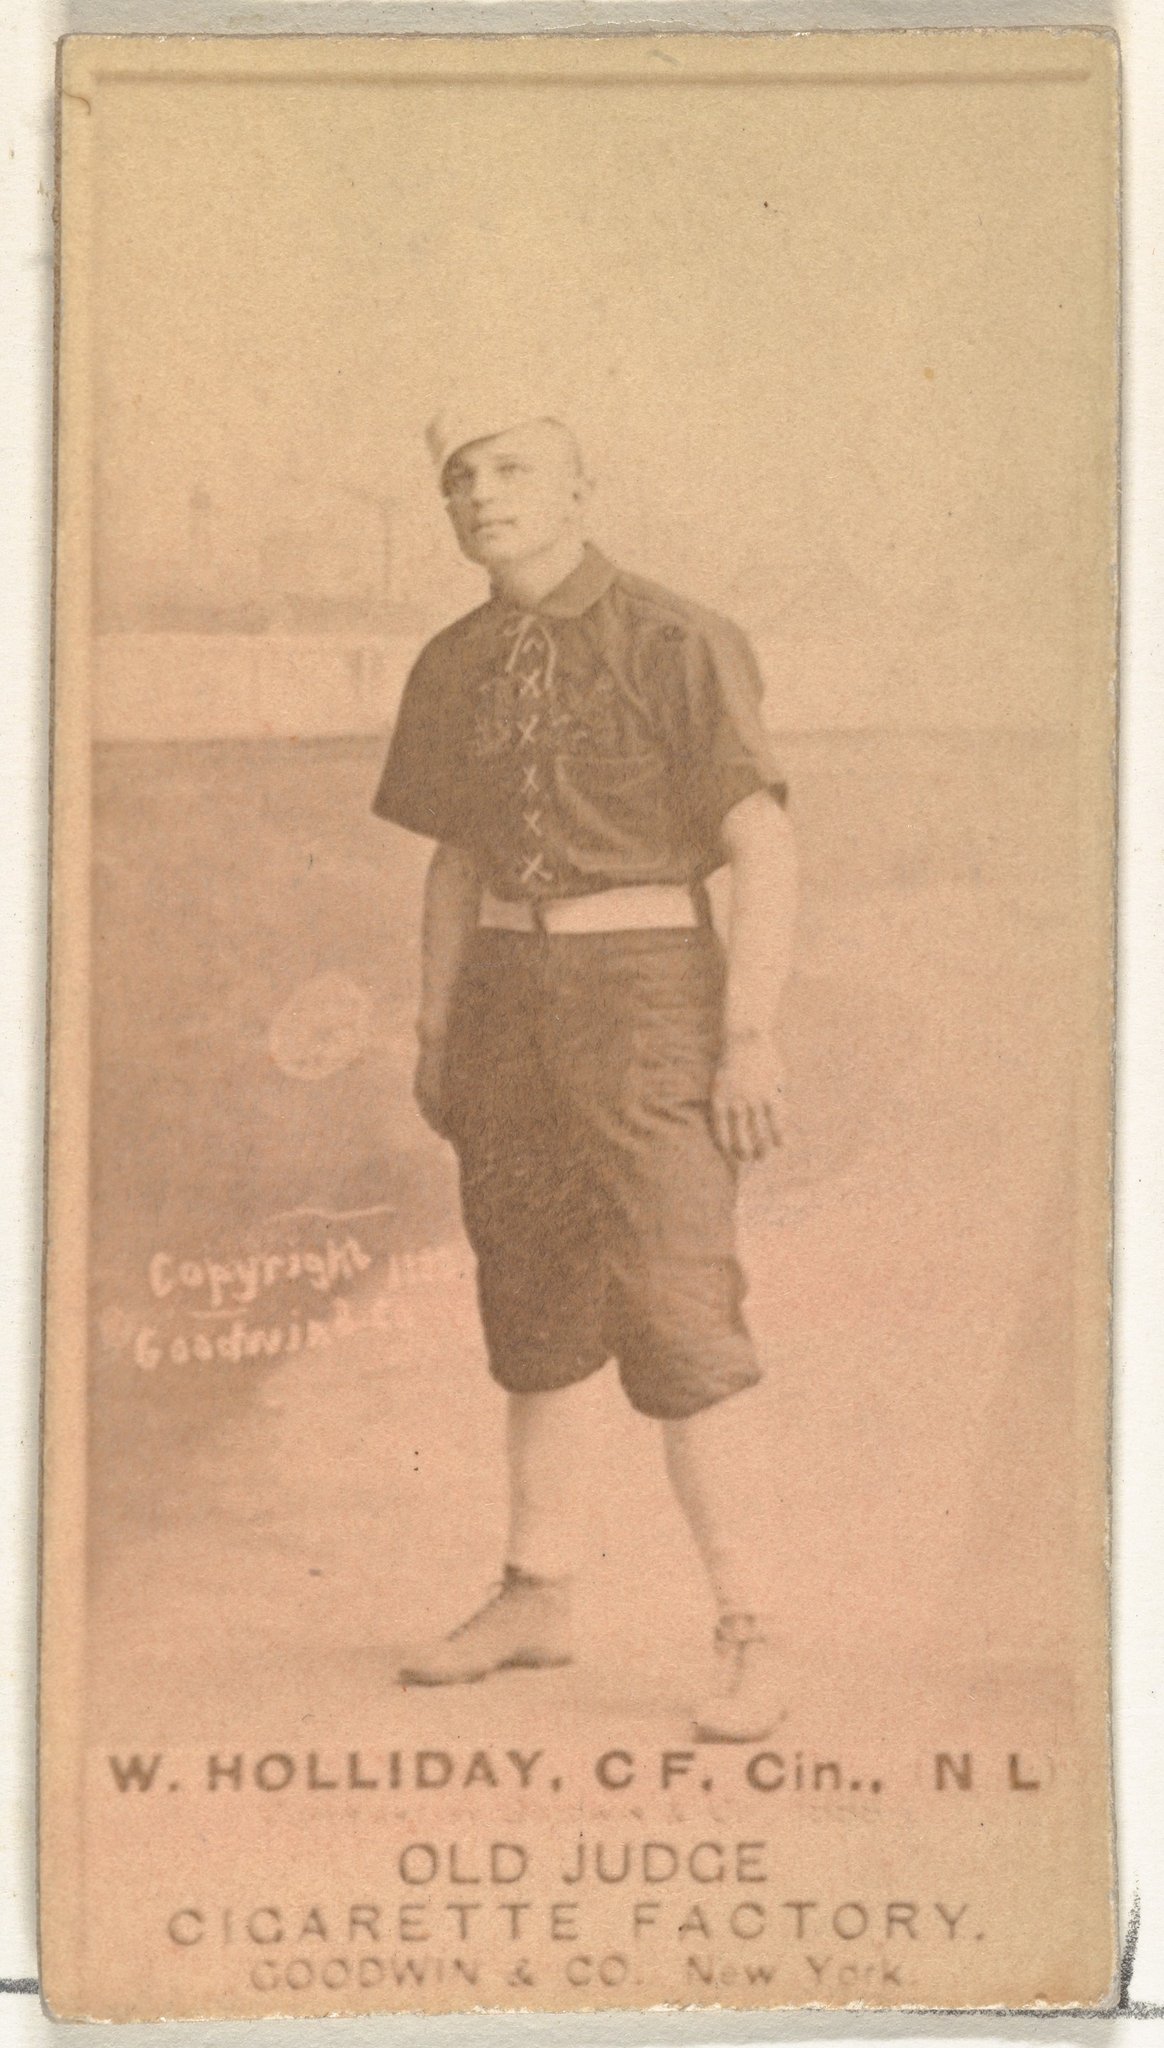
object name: baseball card, photograph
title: James Wear "Bug" Holliday, Center Field, Cincinnati, from the Old Judge series (N172) for Old Judge Cigarettes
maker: goodwin & company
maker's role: publisher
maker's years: 1850-1950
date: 1888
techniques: albumen silver print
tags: men,portraits,baseball,athletes